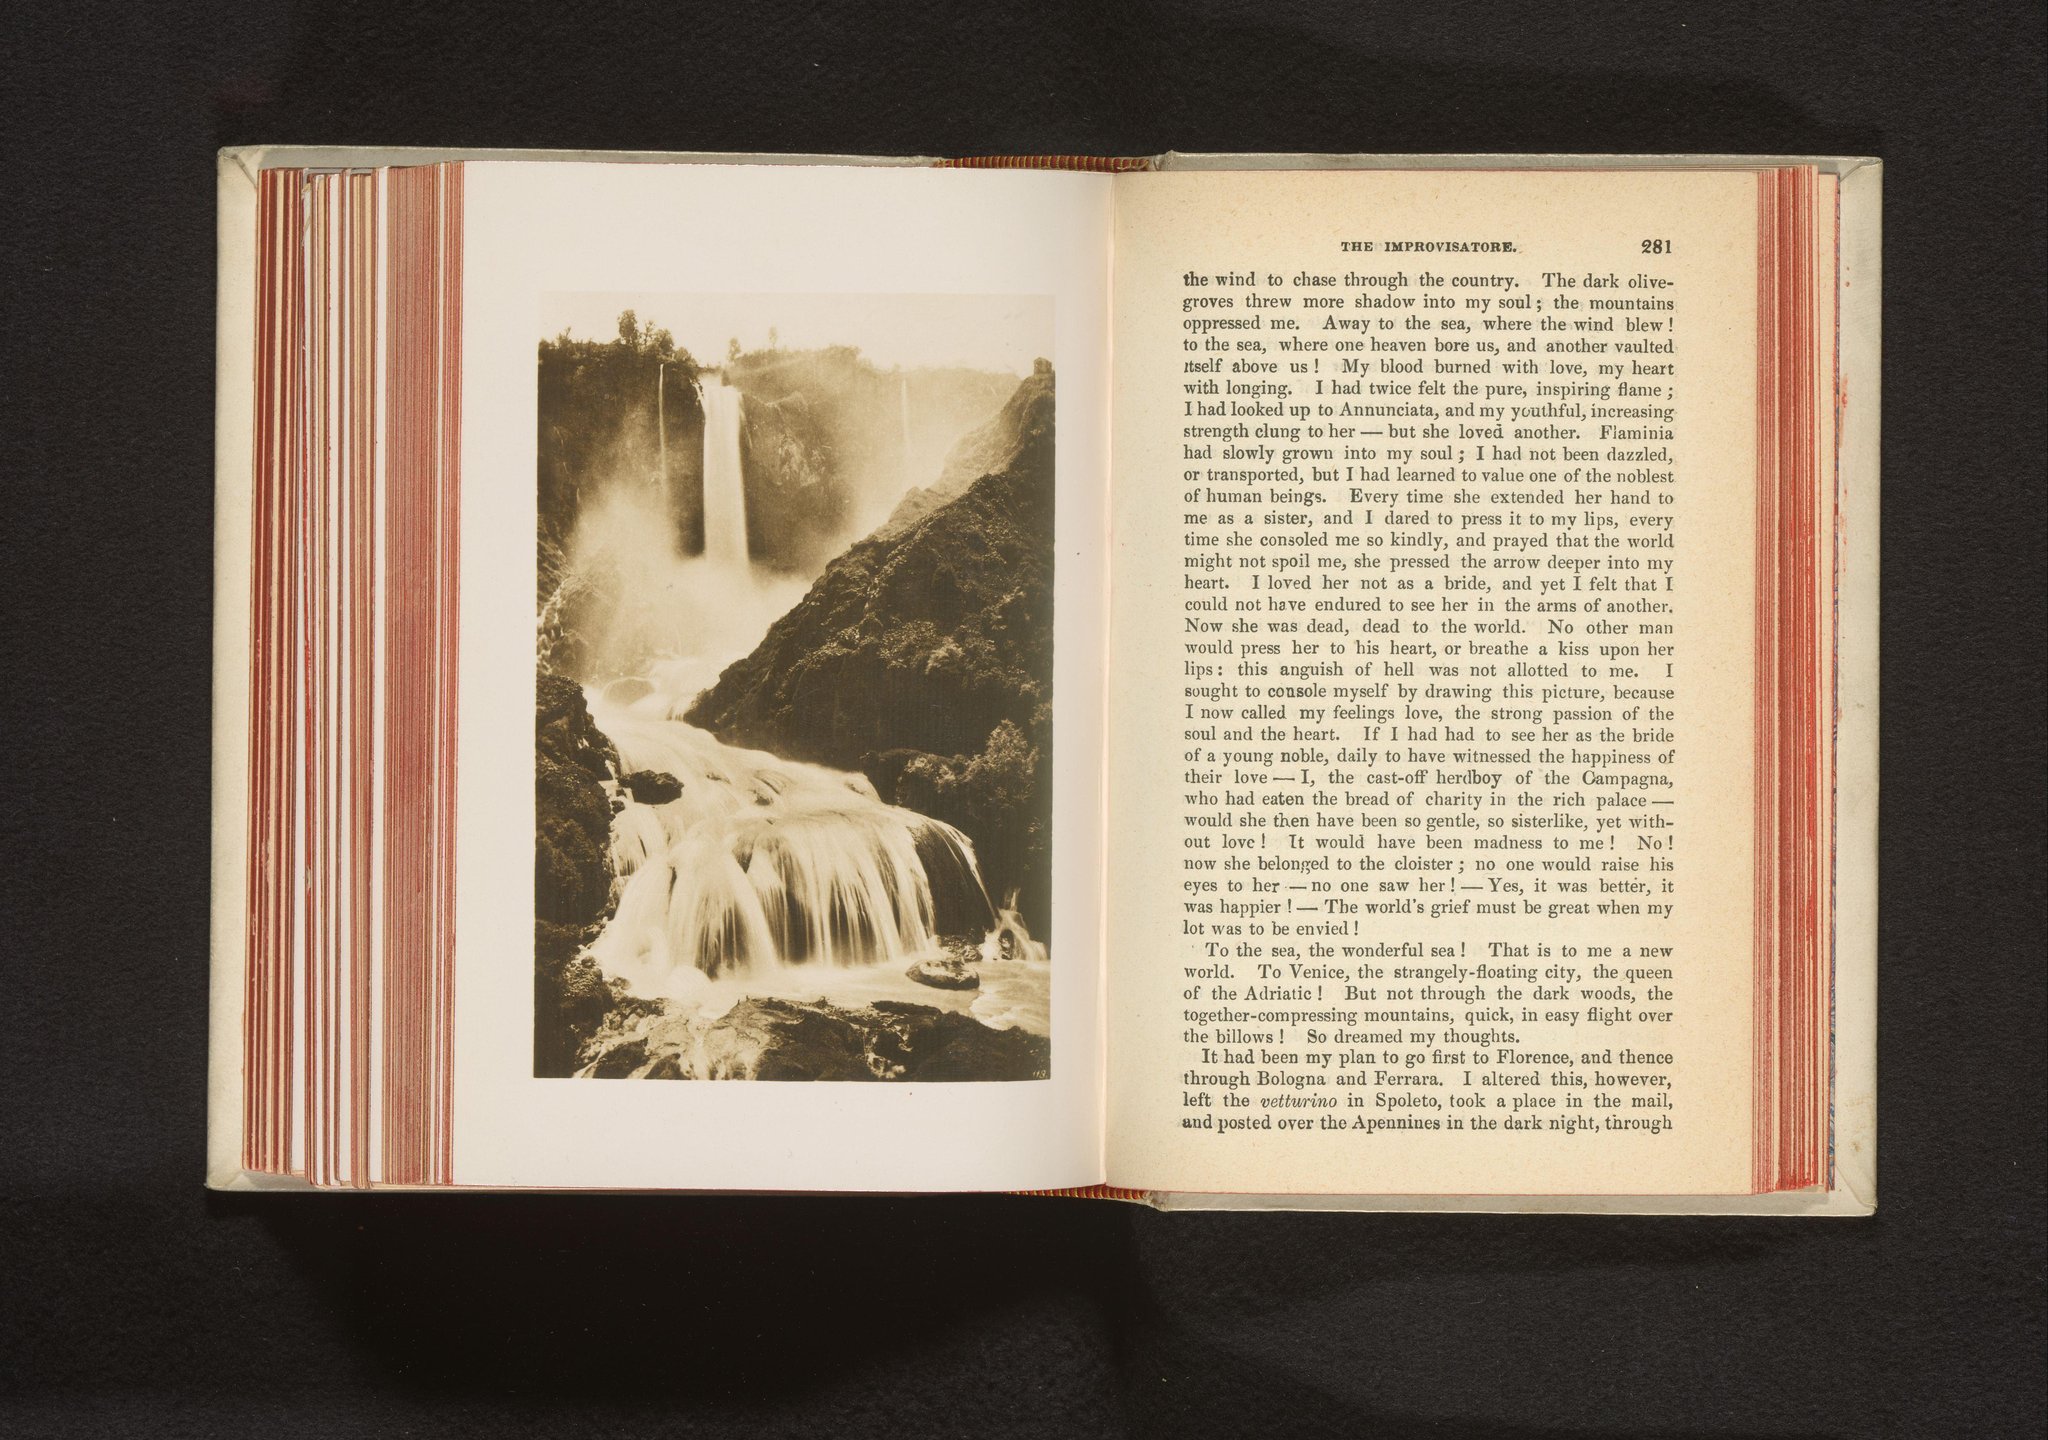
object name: photograph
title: Waterval (vermoedelijk) nabij Tivoli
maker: Anonymous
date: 1870-1880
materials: photographic support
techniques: gelatin silver print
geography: lazio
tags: waterfall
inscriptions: number: ‘113.’